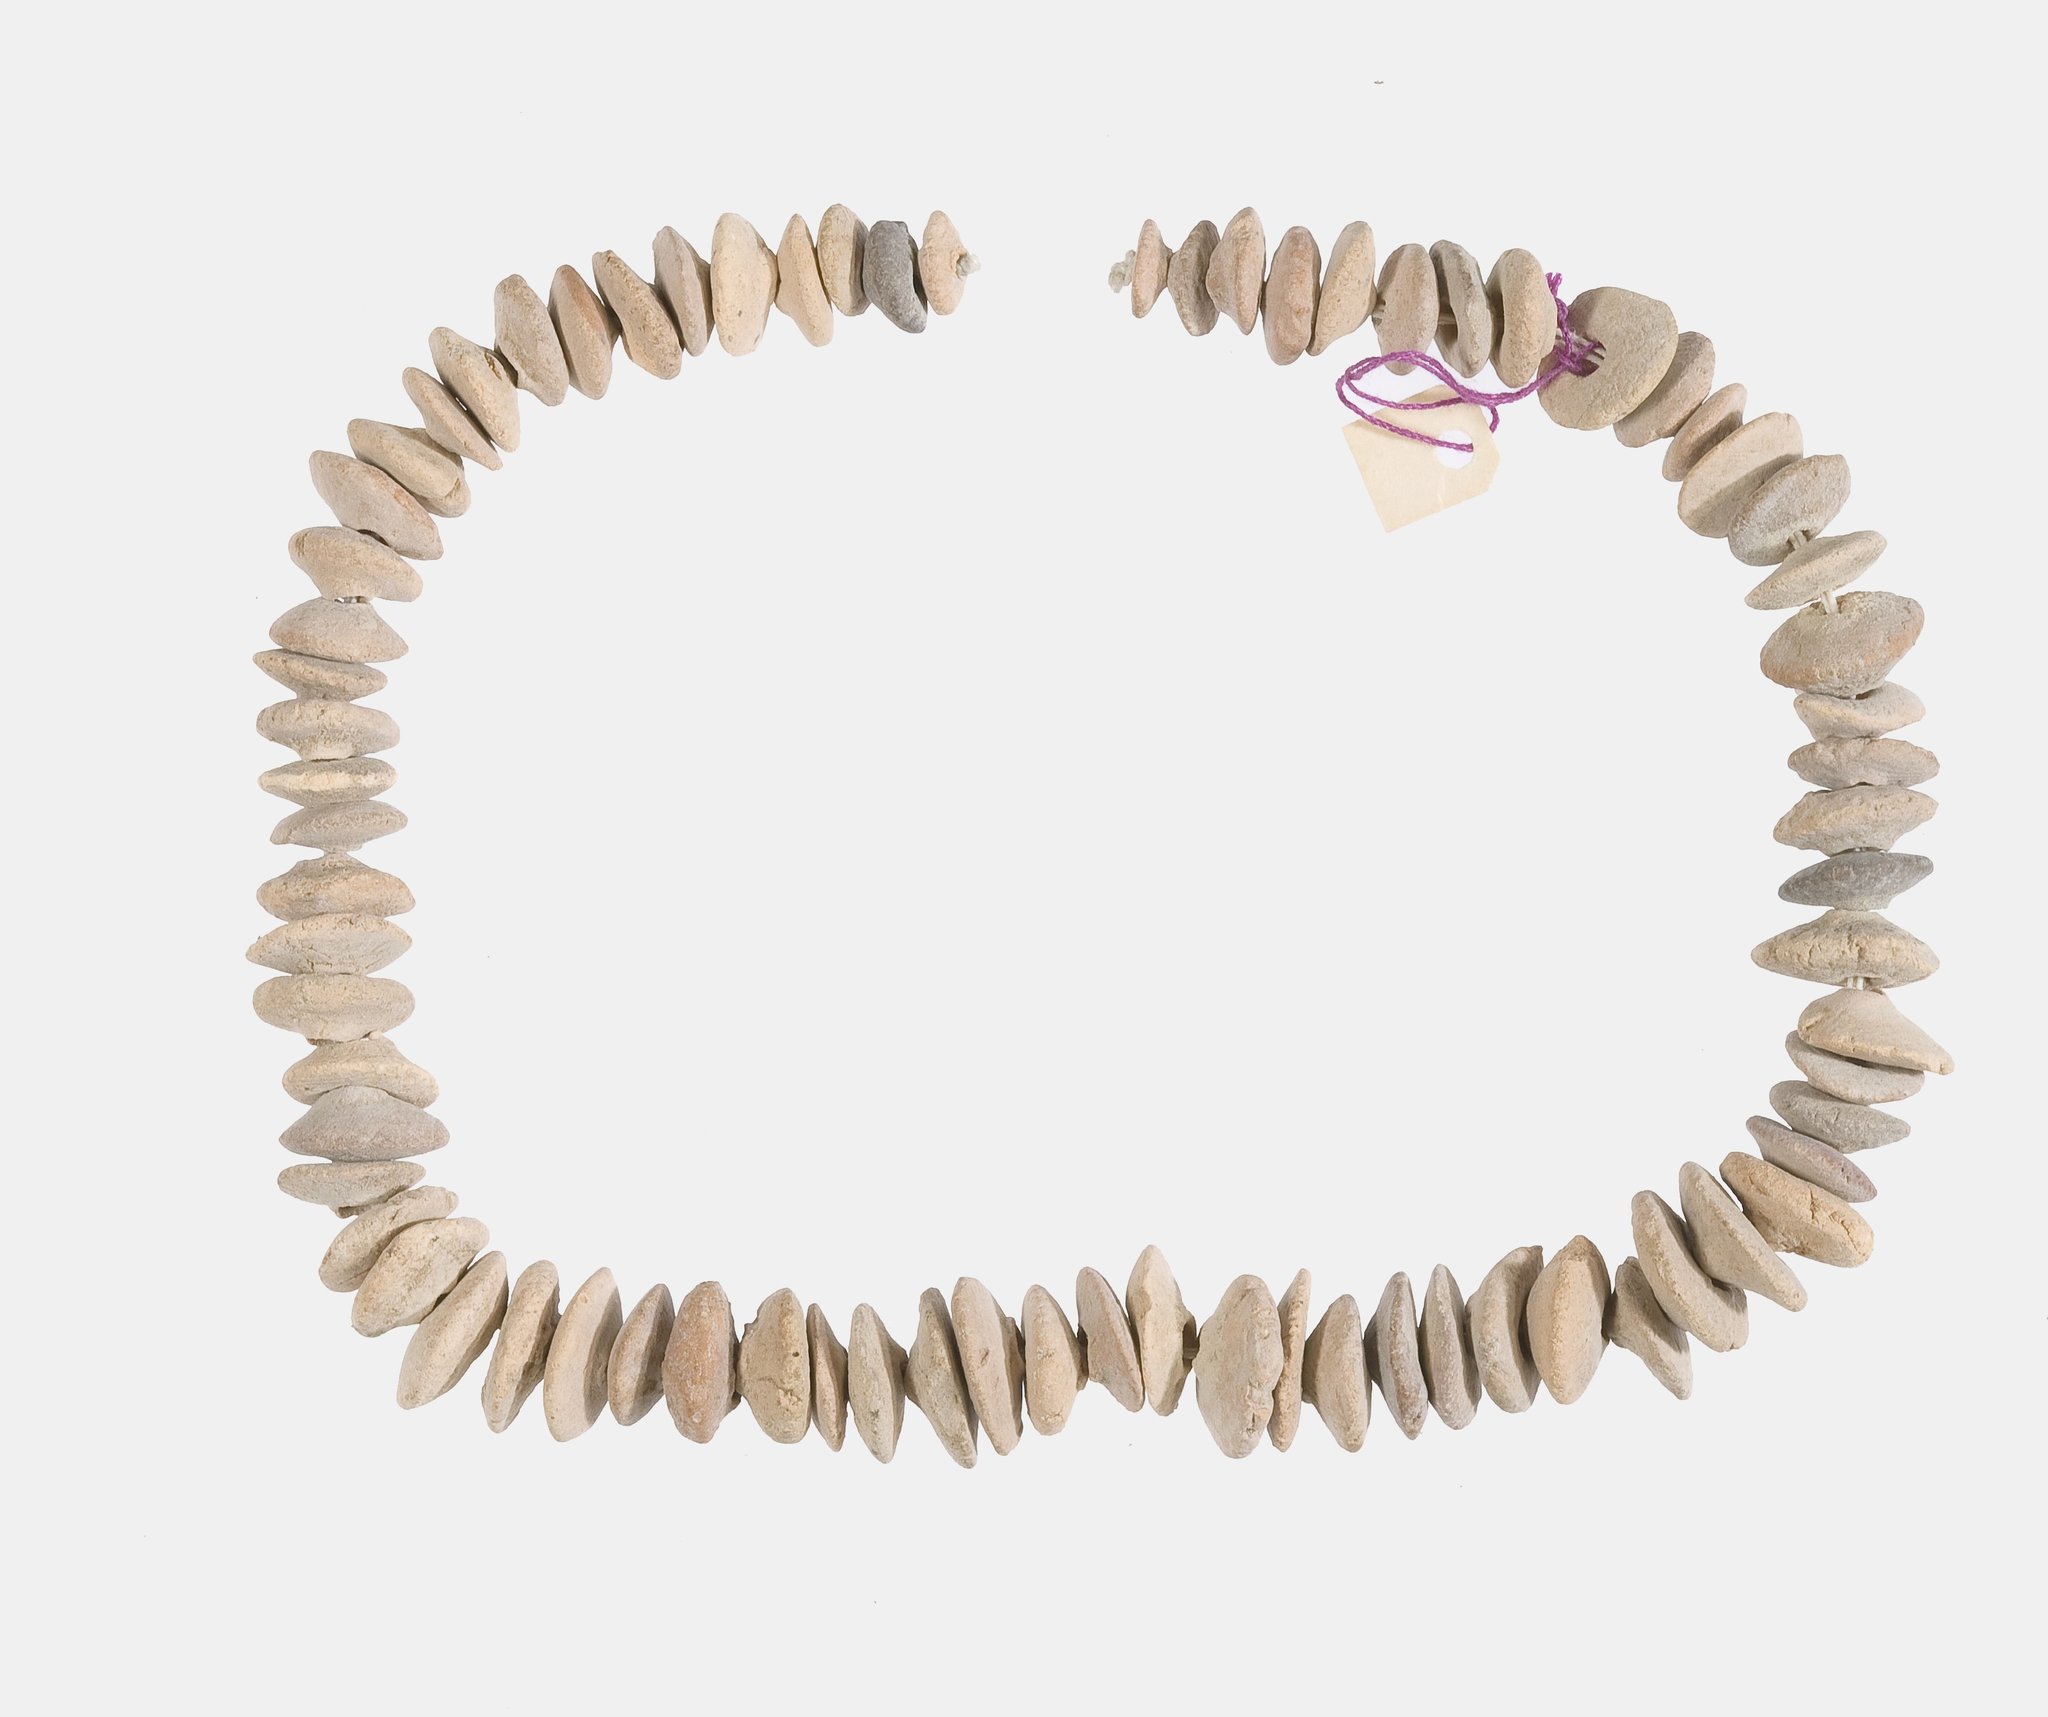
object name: necklace, bead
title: Necklace of white lenticular beads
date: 1802-1450 BCE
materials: faience, pottery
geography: egypt